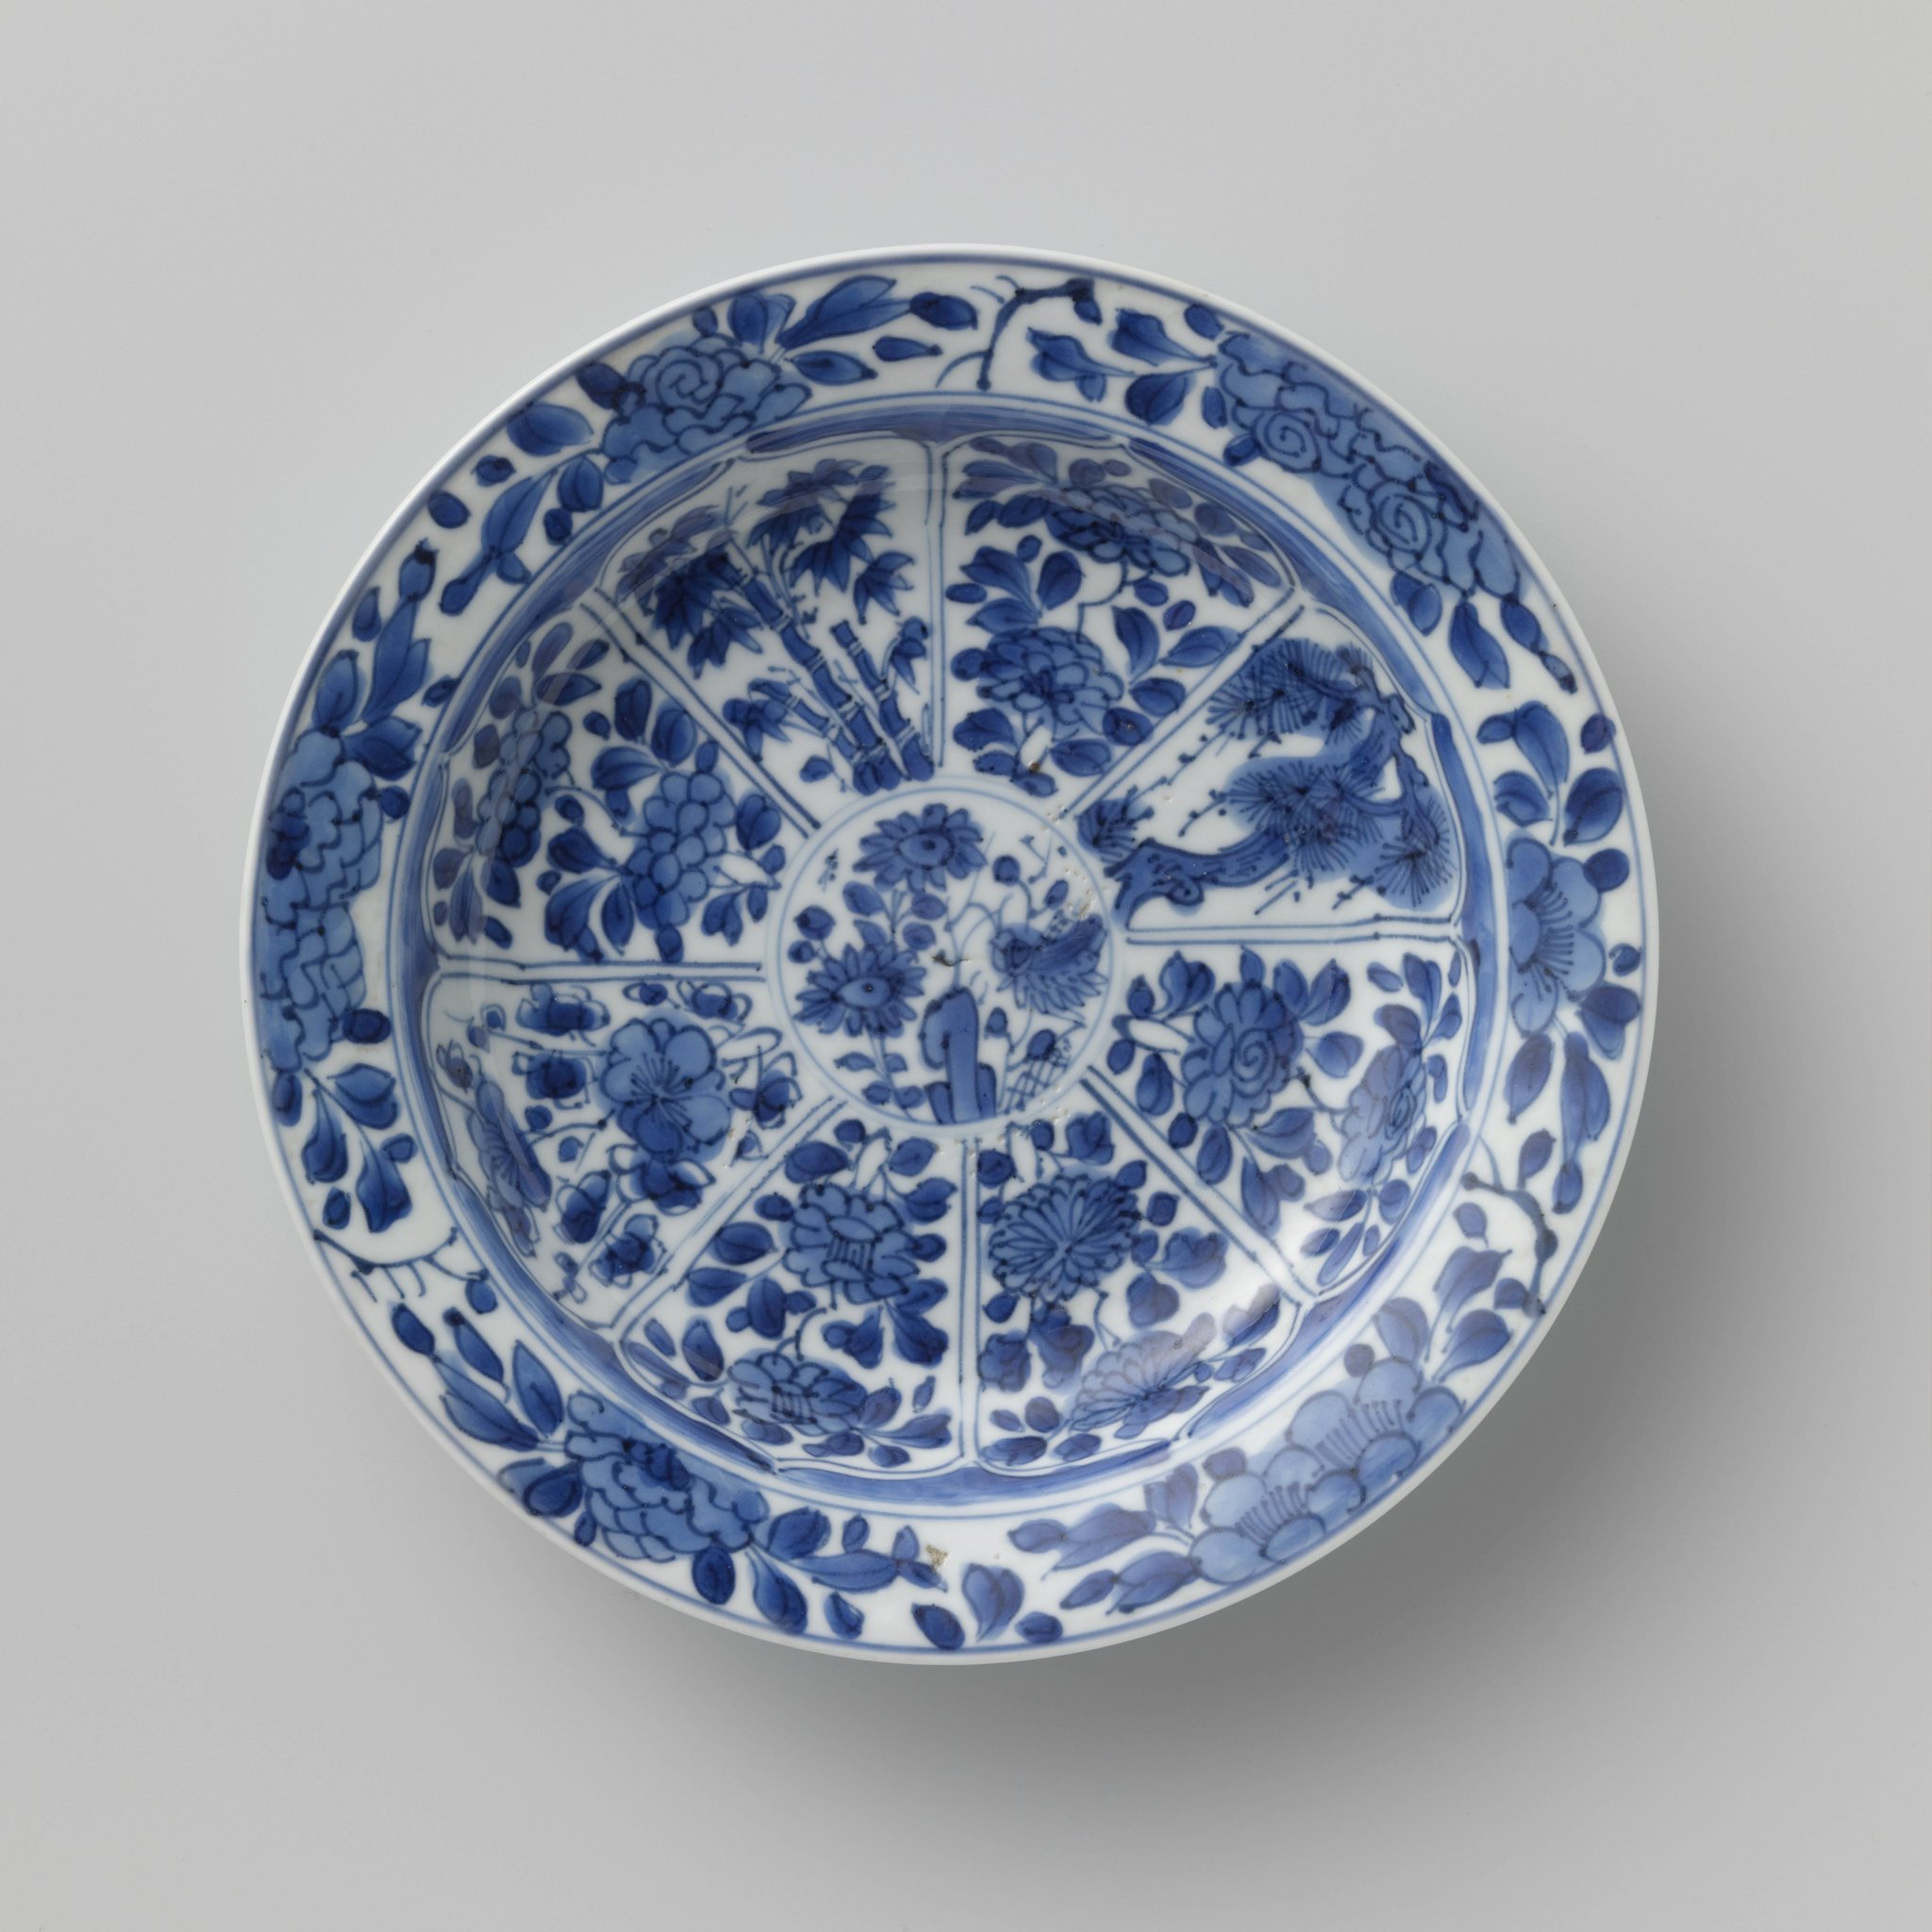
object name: platter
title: Saucer with panels in the shape of a flowerhead filled with flower sprays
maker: Anonymous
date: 1680-1720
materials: cobalt, glaze, paint, porcelain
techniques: firing, turning, vitrification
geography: china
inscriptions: mark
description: Schotels, plat in acht accoladevormige vakken verdeeld gevuld met verschillende voorstellingen, rand heeft bloem- en bladermotief.